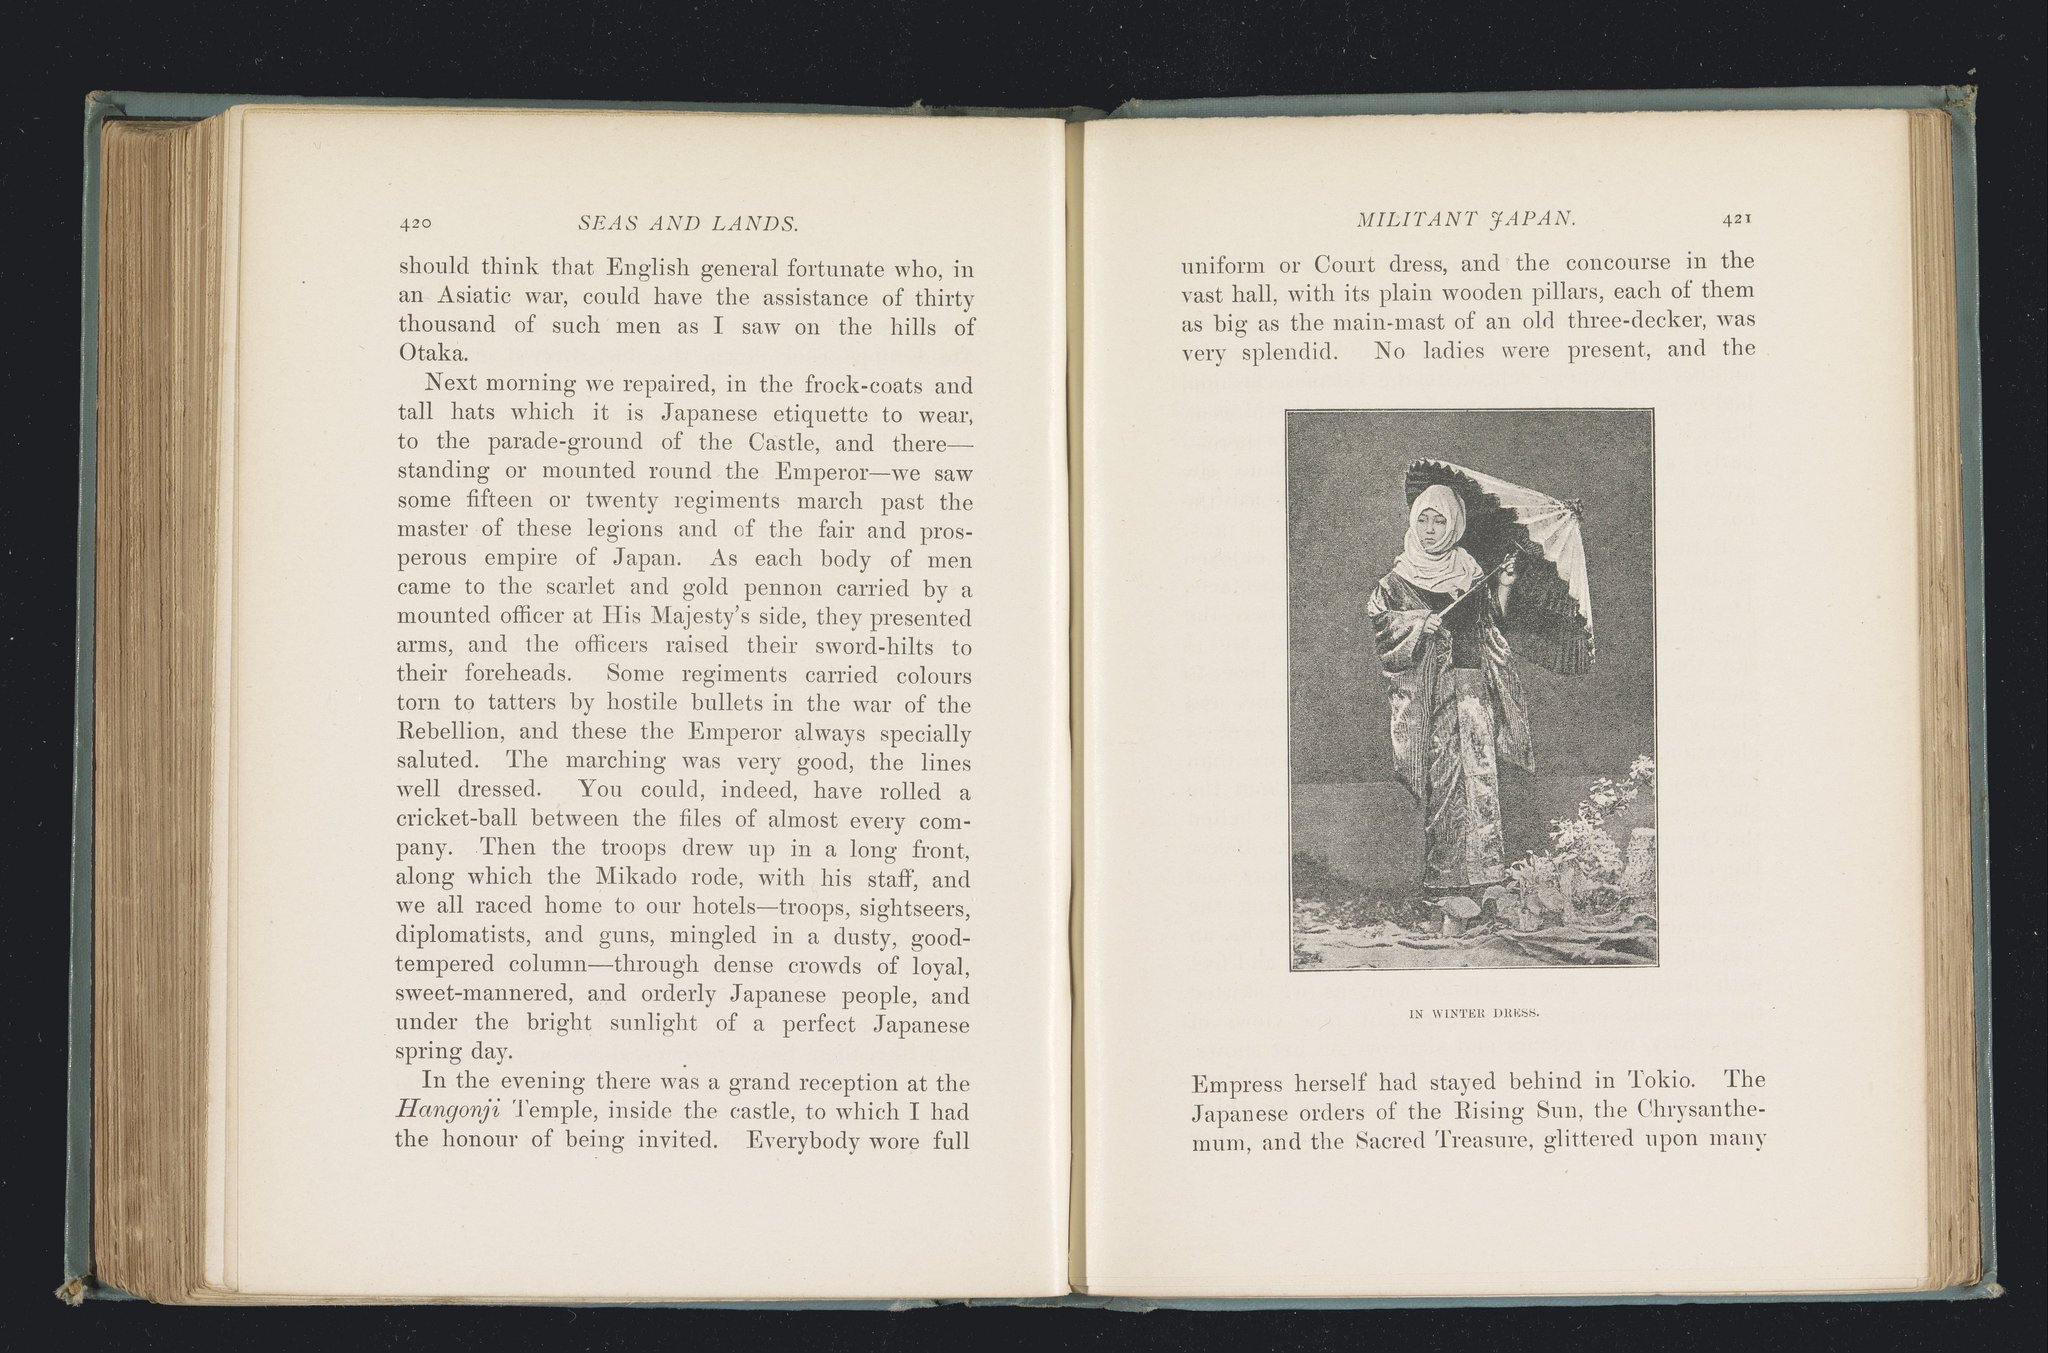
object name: photomechanical print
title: In winter dress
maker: Anonymous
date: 1882-1892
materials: paper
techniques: autotype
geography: japan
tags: adult woman, parasol, sunshade